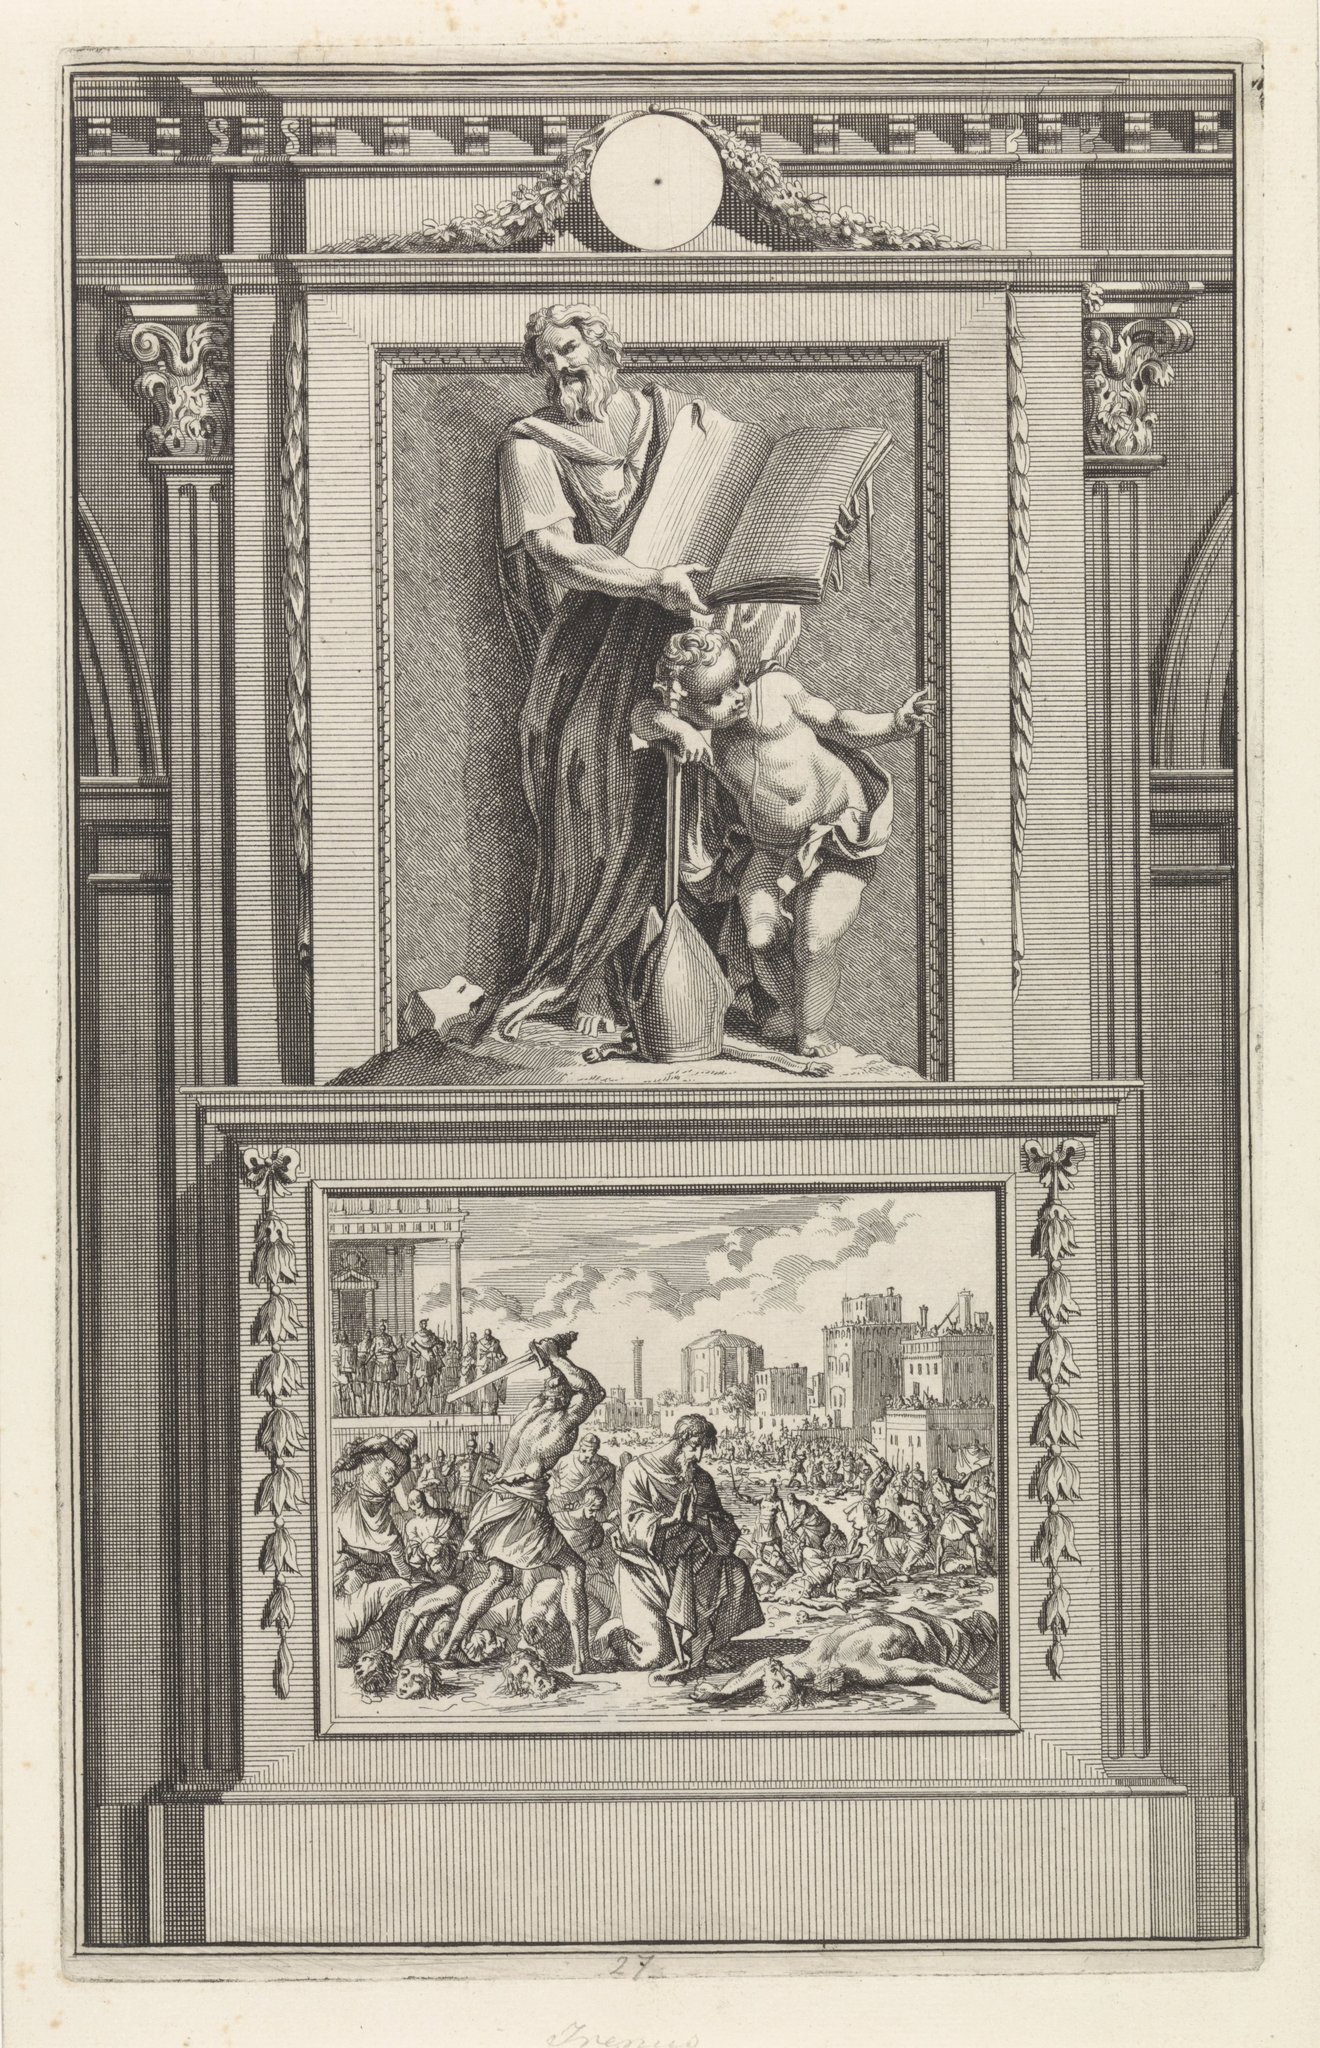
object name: print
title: H. Ireneüs van Lyon, kerkvader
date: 1698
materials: paper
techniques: engraving, etching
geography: amsterdam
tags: male saints (irenaeus of lyon), violent death by beheading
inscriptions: number: ‘27’, collector's mark: Lugt 2228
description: De heilige kerkvader Ireneüs van Lyon staat met een geopend boek in zijn handen. Naast hem steunt een engel op een zwaard dat in een bisschopsmijter is gestoken. Ireneüs staat op een sokkel waar op de voorzijde zijn onthoofding in beeld is gebracht.